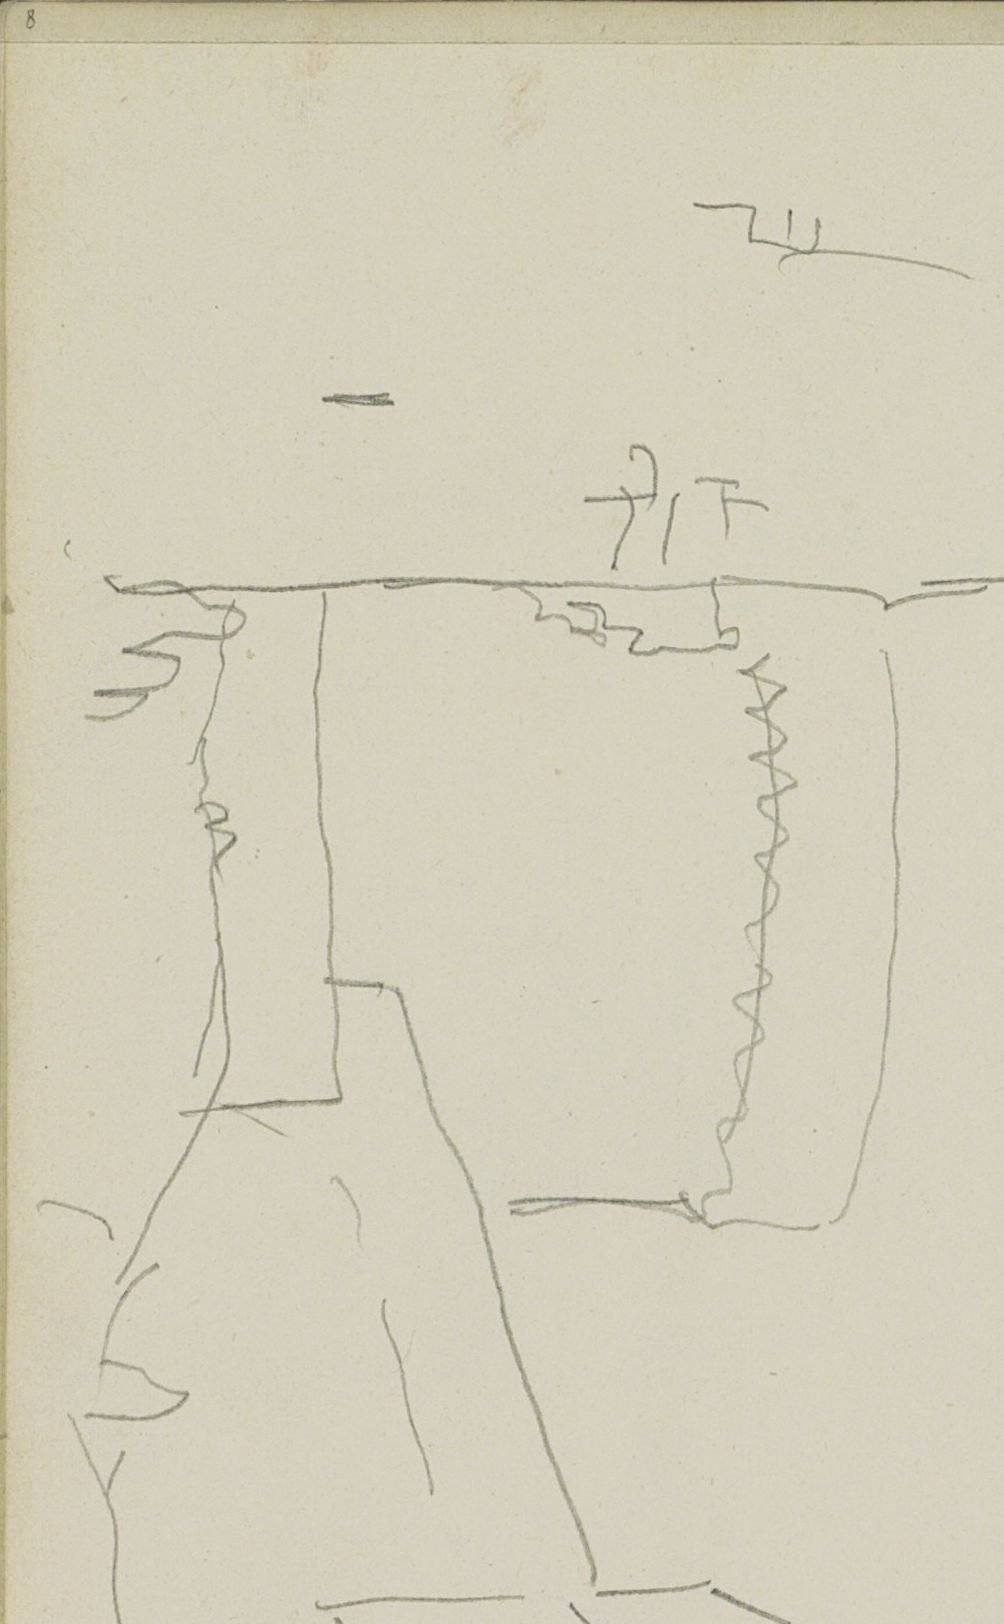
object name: sketchbook leaf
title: Citadel van Caïro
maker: marius bauer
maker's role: draughtsman, print maker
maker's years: 1867-1932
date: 1904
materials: paper, pencil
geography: cairo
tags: towers ~ fortified city, walls ~ fortified city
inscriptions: kleurnotitie, handgeschreven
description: Pagina 8 uit een schetsboek met 56 bladen.